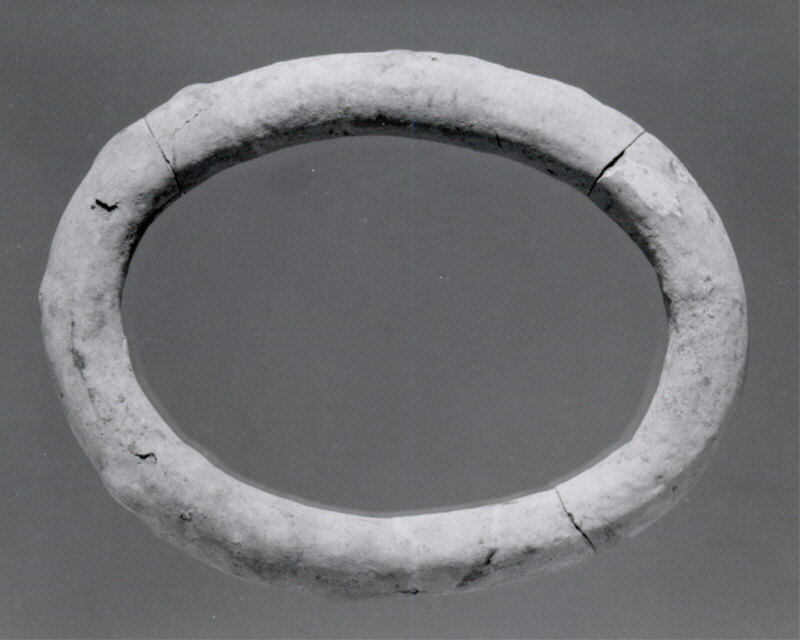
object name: loop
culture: iranian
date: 900-801 BCE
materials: glass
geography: iran